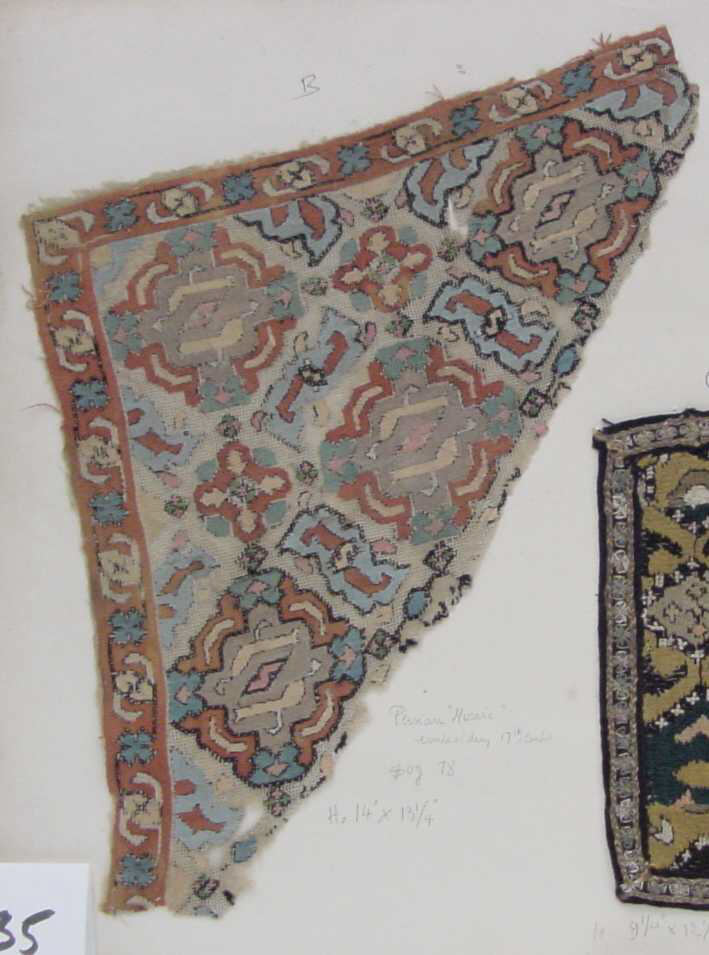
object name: textile fragment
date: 1601-1700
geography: iran